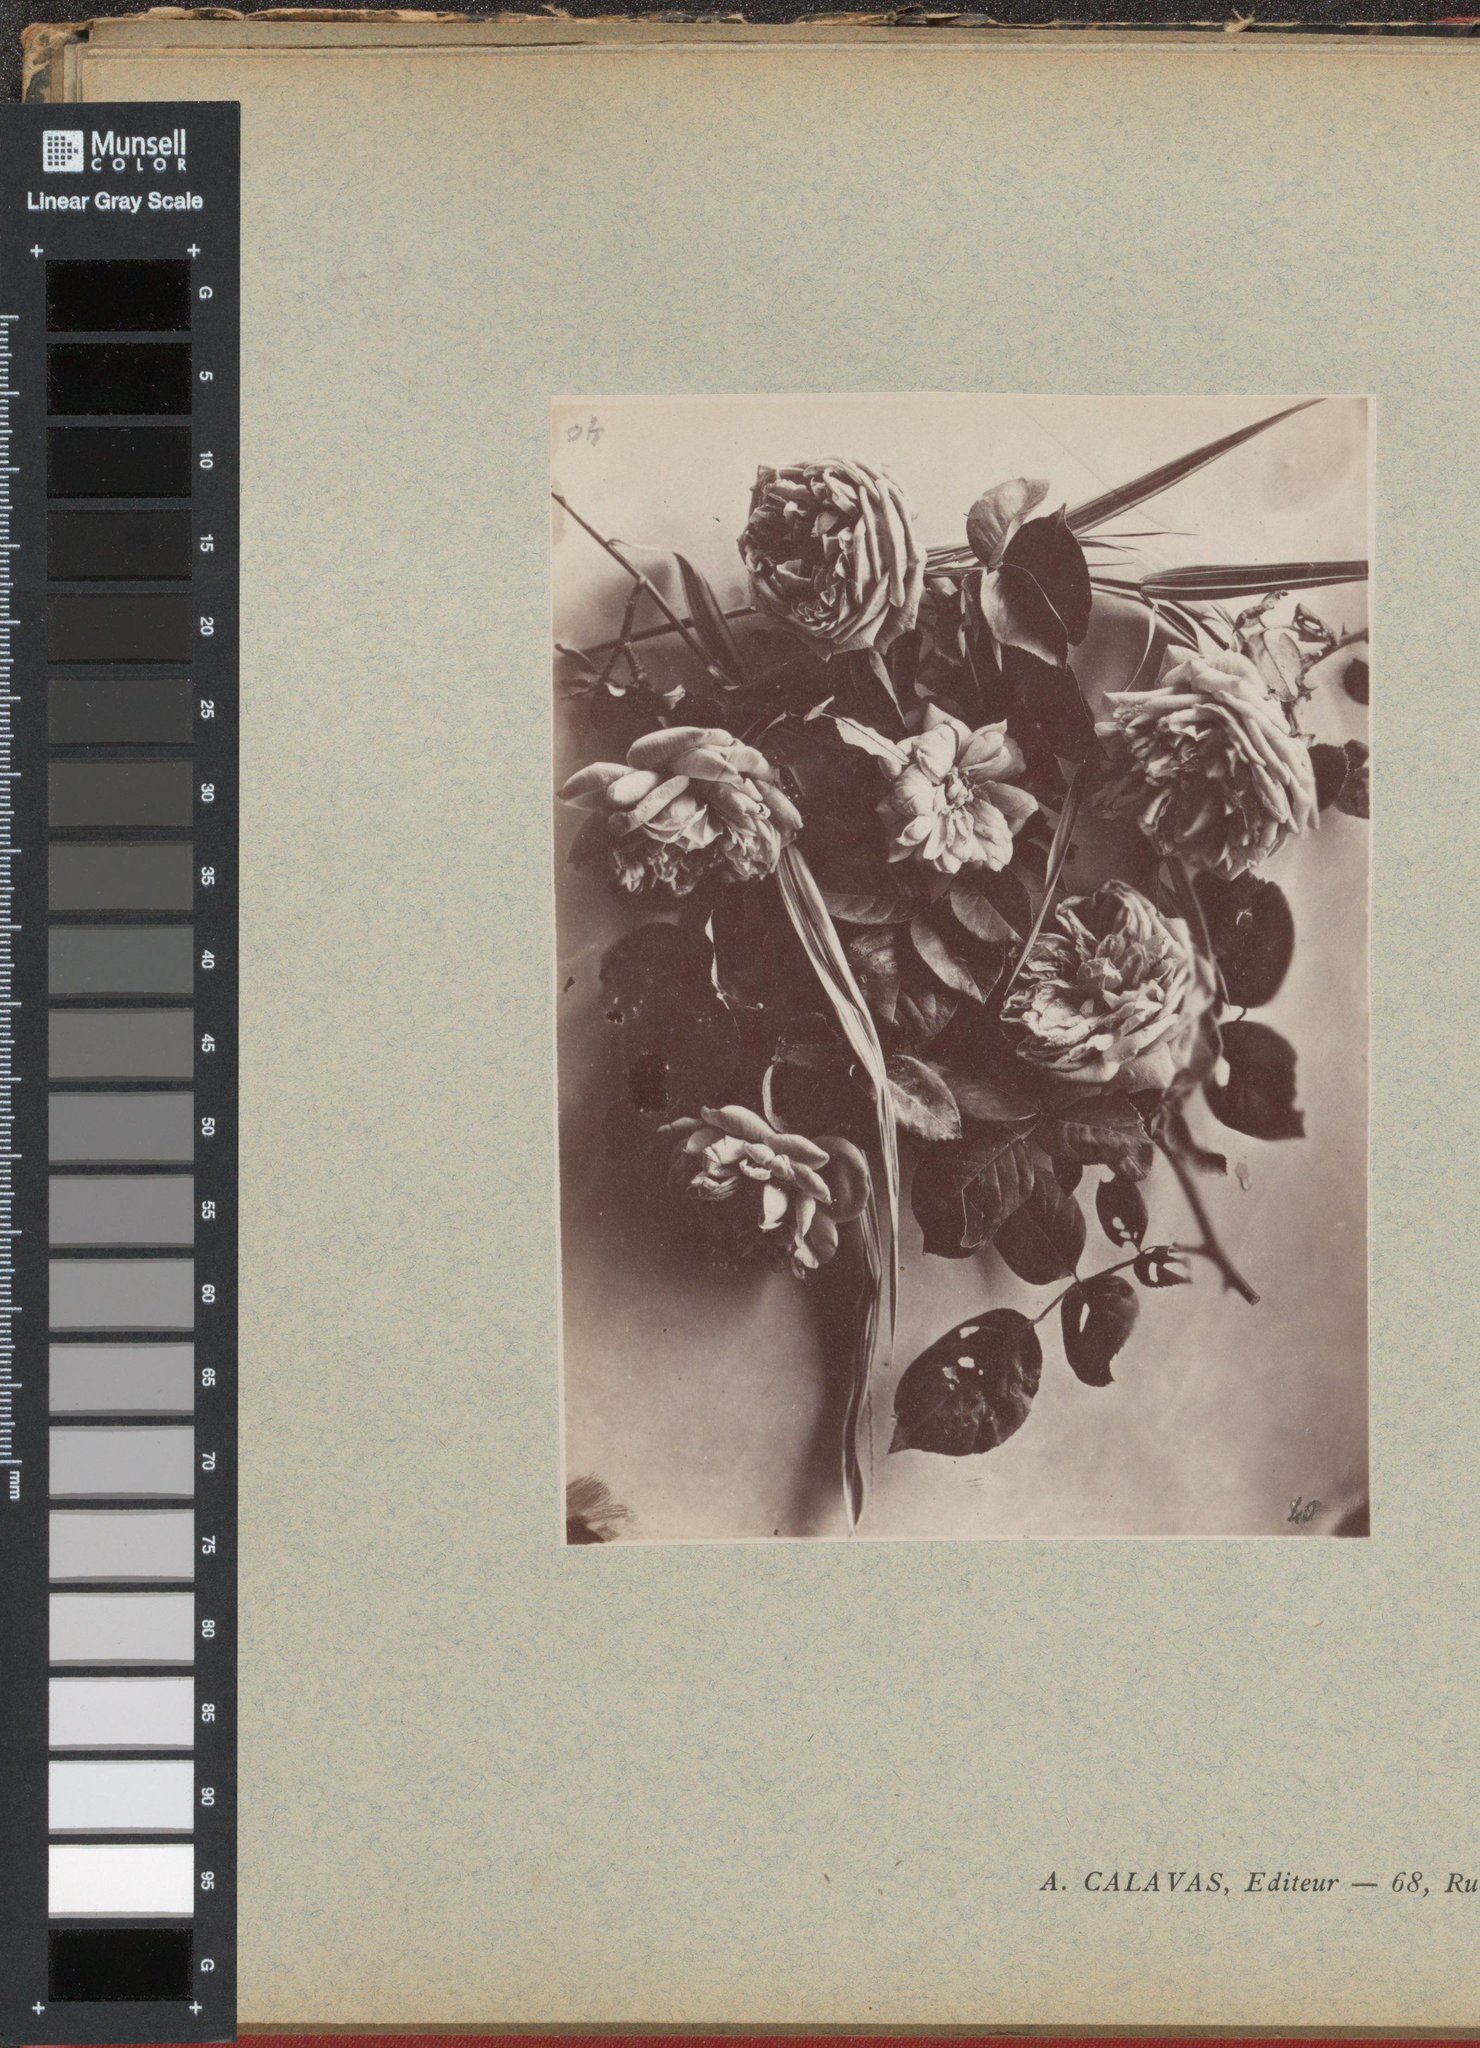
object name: photograph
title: Bloemstudie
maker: a. calavas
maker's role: publisher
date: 1875-1895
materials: cardboard, photographic support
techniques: albumen print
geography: paris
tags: flowers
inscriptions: number: ‘40’, collector's mark: Lugt 3937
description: Onderdeel van Verzamelband met foto's van bloemstudies.